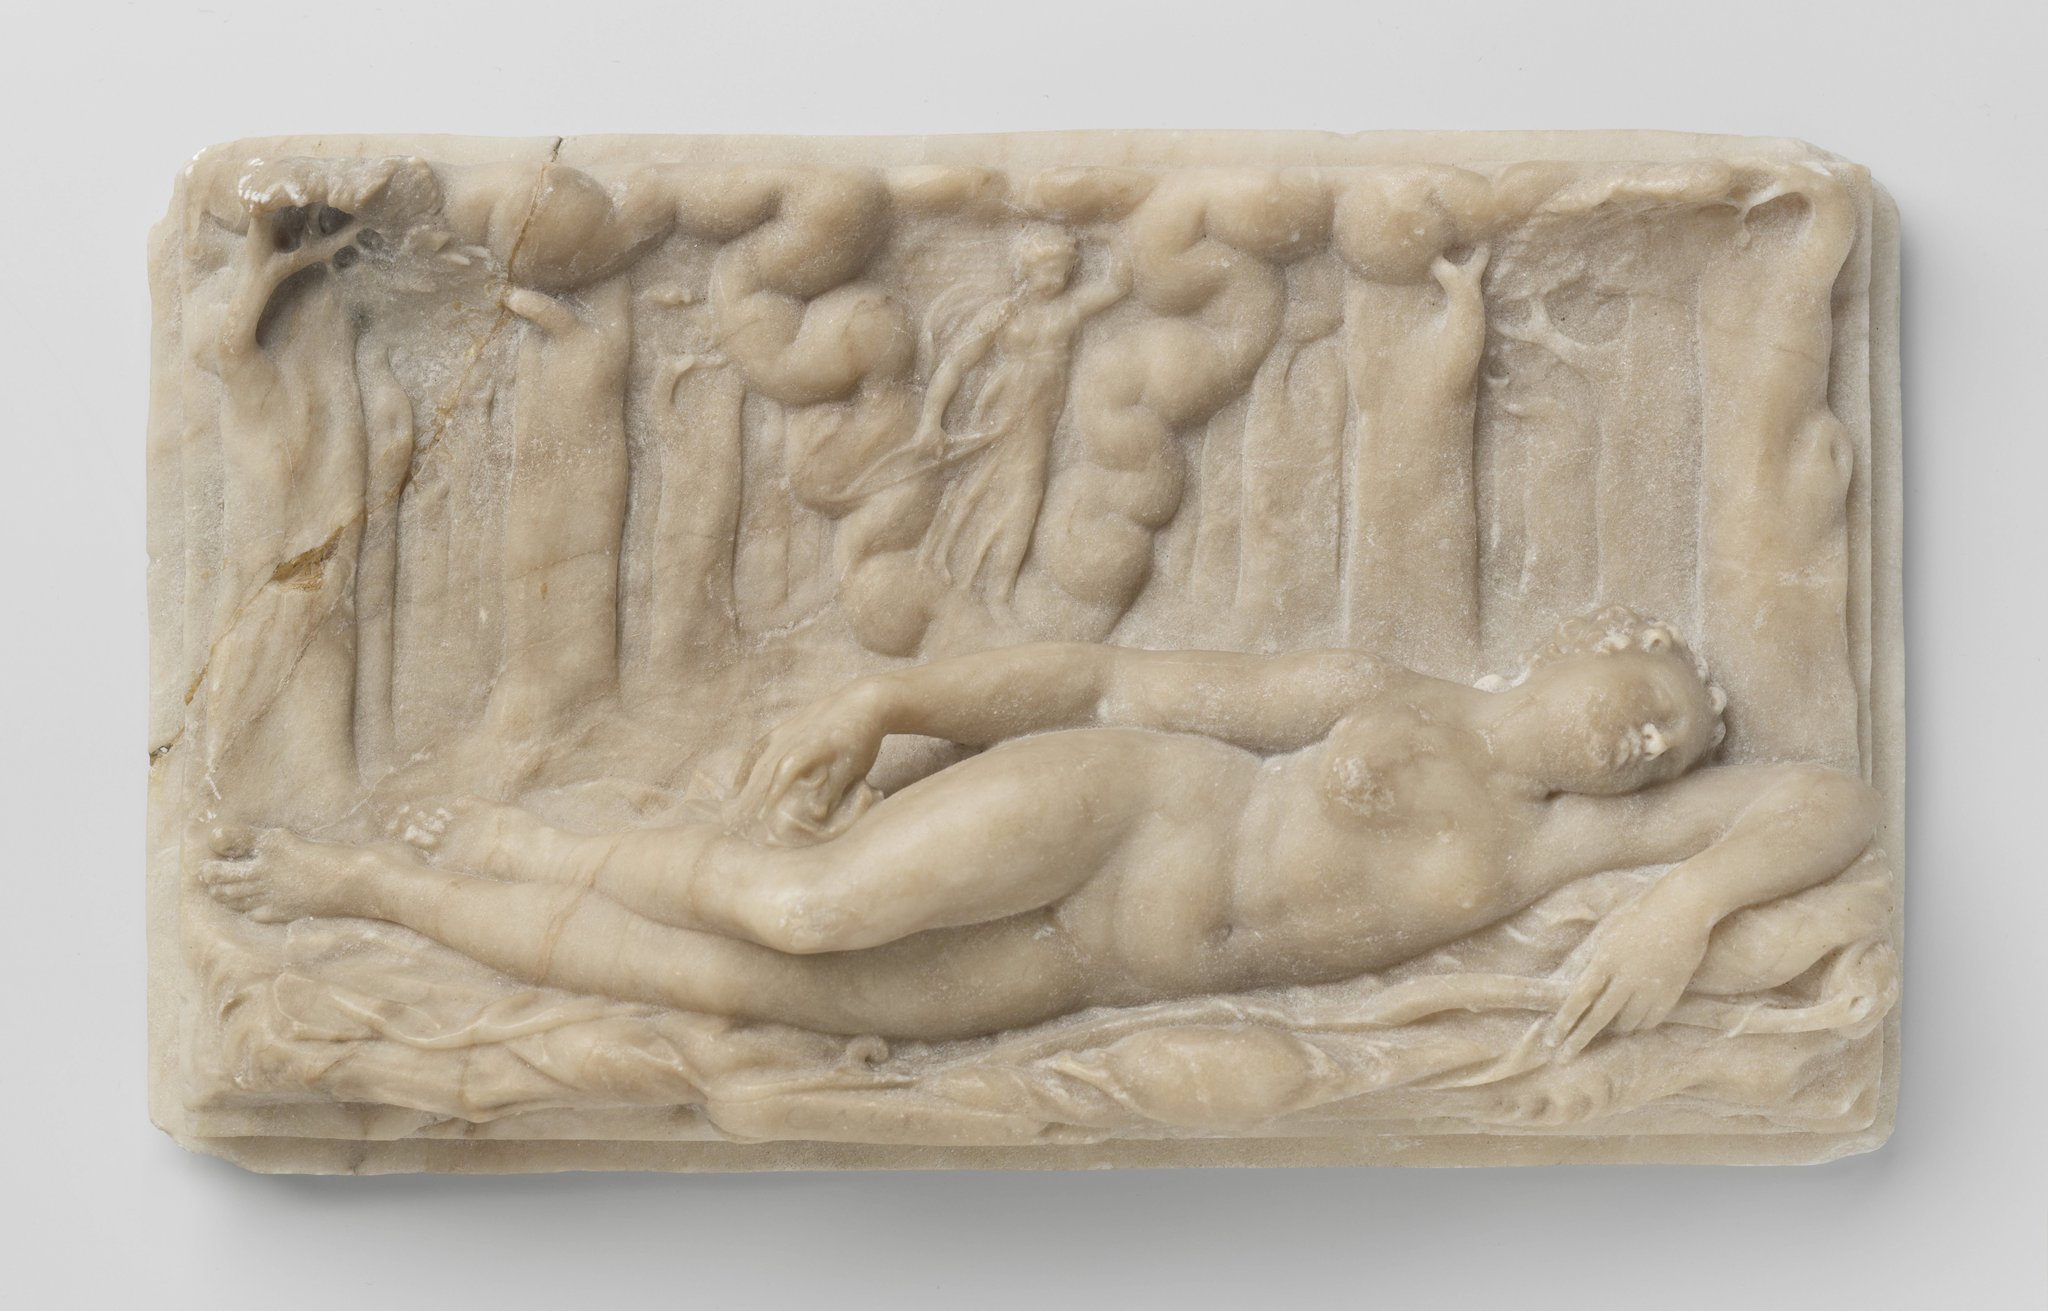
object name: relief sculpture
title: Callisto Sleeping in a Forest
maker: Anonymous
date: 1600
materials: alabaster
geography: mechelen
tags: (story of) callisto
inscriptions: inscription, on the inclined cartouche below the scene, in recessed relief: ‘CALISTO’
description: De bosnimf ligt languit en geheel naakt op een kleed. Onder een van haar armen is nog juist een pijlkoker zichtbaar en in haar afhangende hand houdt zij losjes een boog. Op de achtergrond zware boomstammen met in het midden een wolk waarin een naar rechts zwevende vrouwenfiguur met boog: Diana. Vooraan, tegen het kleed, een paneeltje waarop: CALISTO.